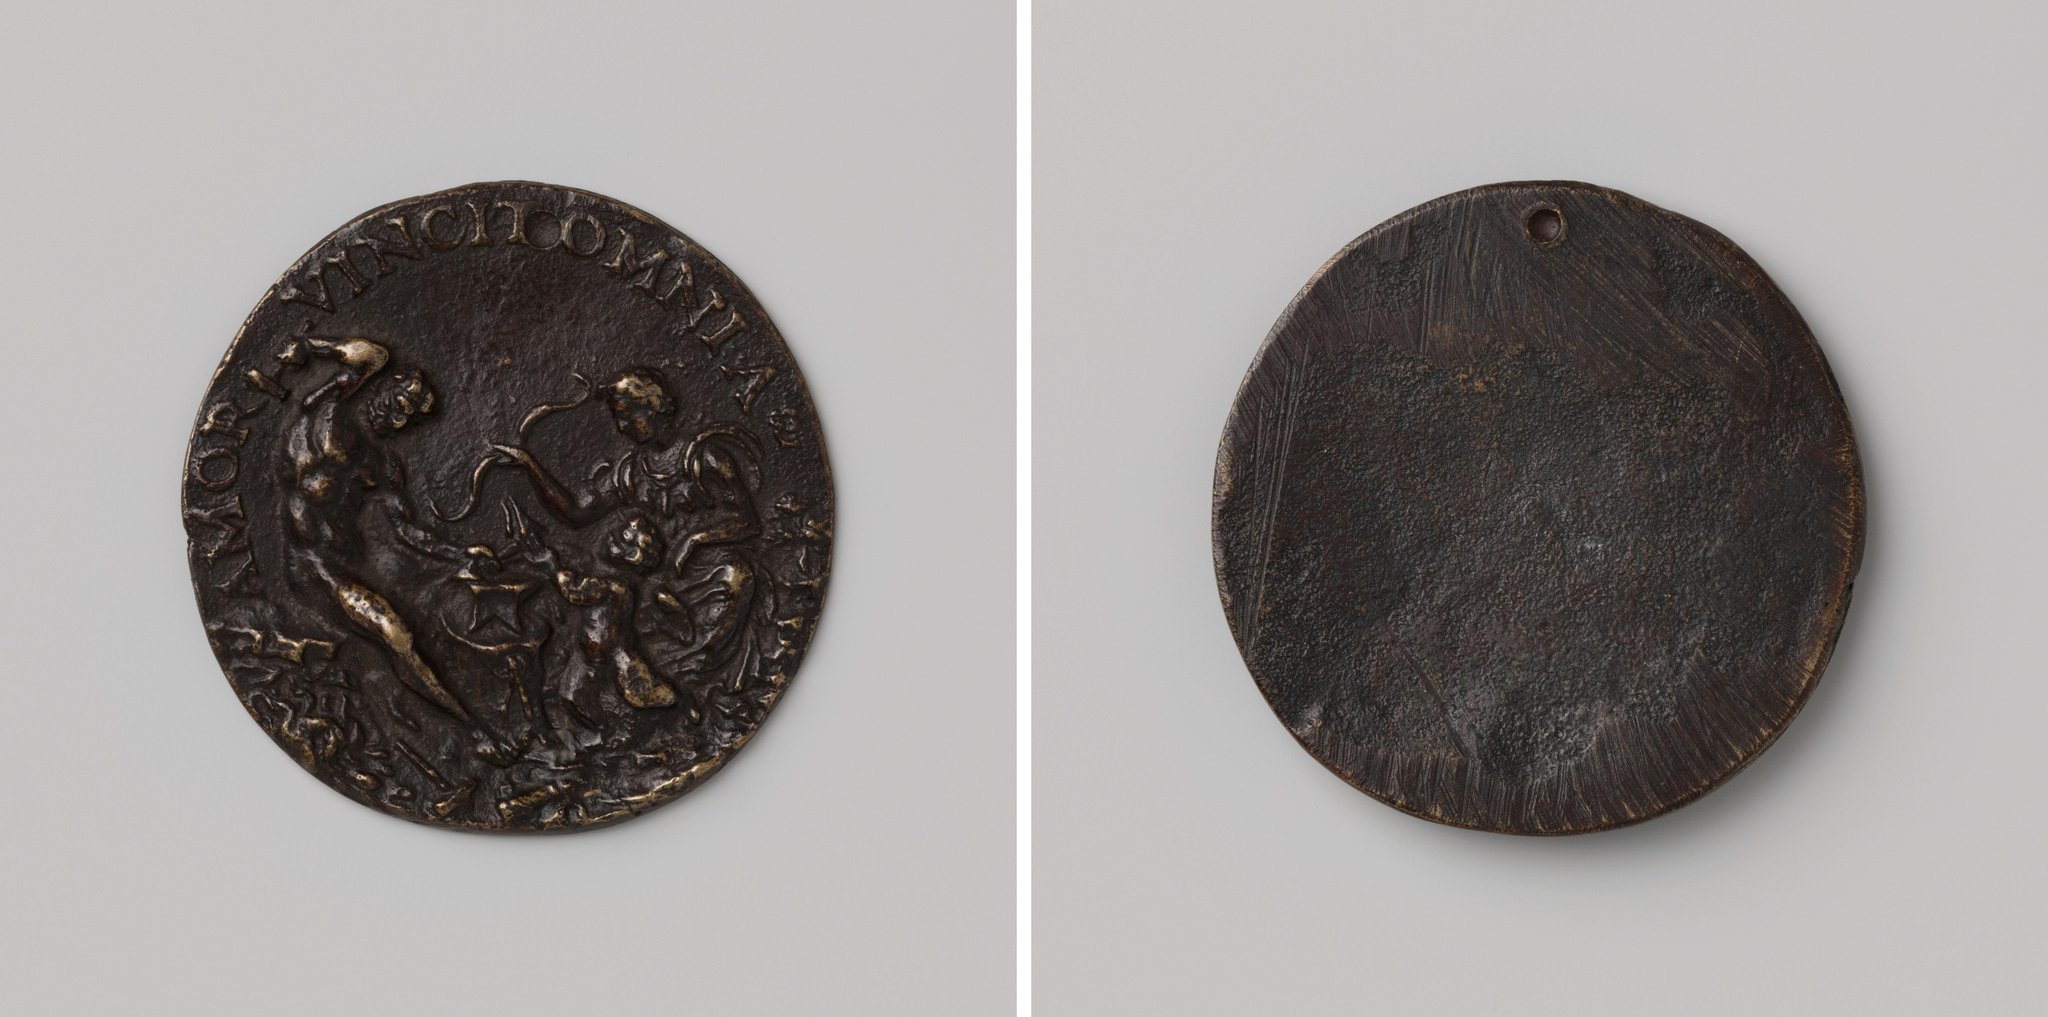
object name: plaque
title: Vulcanus, Venus en Amor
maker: Anonymous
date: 1500-1550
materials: bronze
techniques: casting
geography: padua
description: Eenzijdige bronzen plaquette. Voorzijde: Vulcanus met voorhamer in geheven rechterhand, Amor en Venus met boog in hand, zittend rondom aanbeeld binnen omschrift. Keerzijde: blanco.